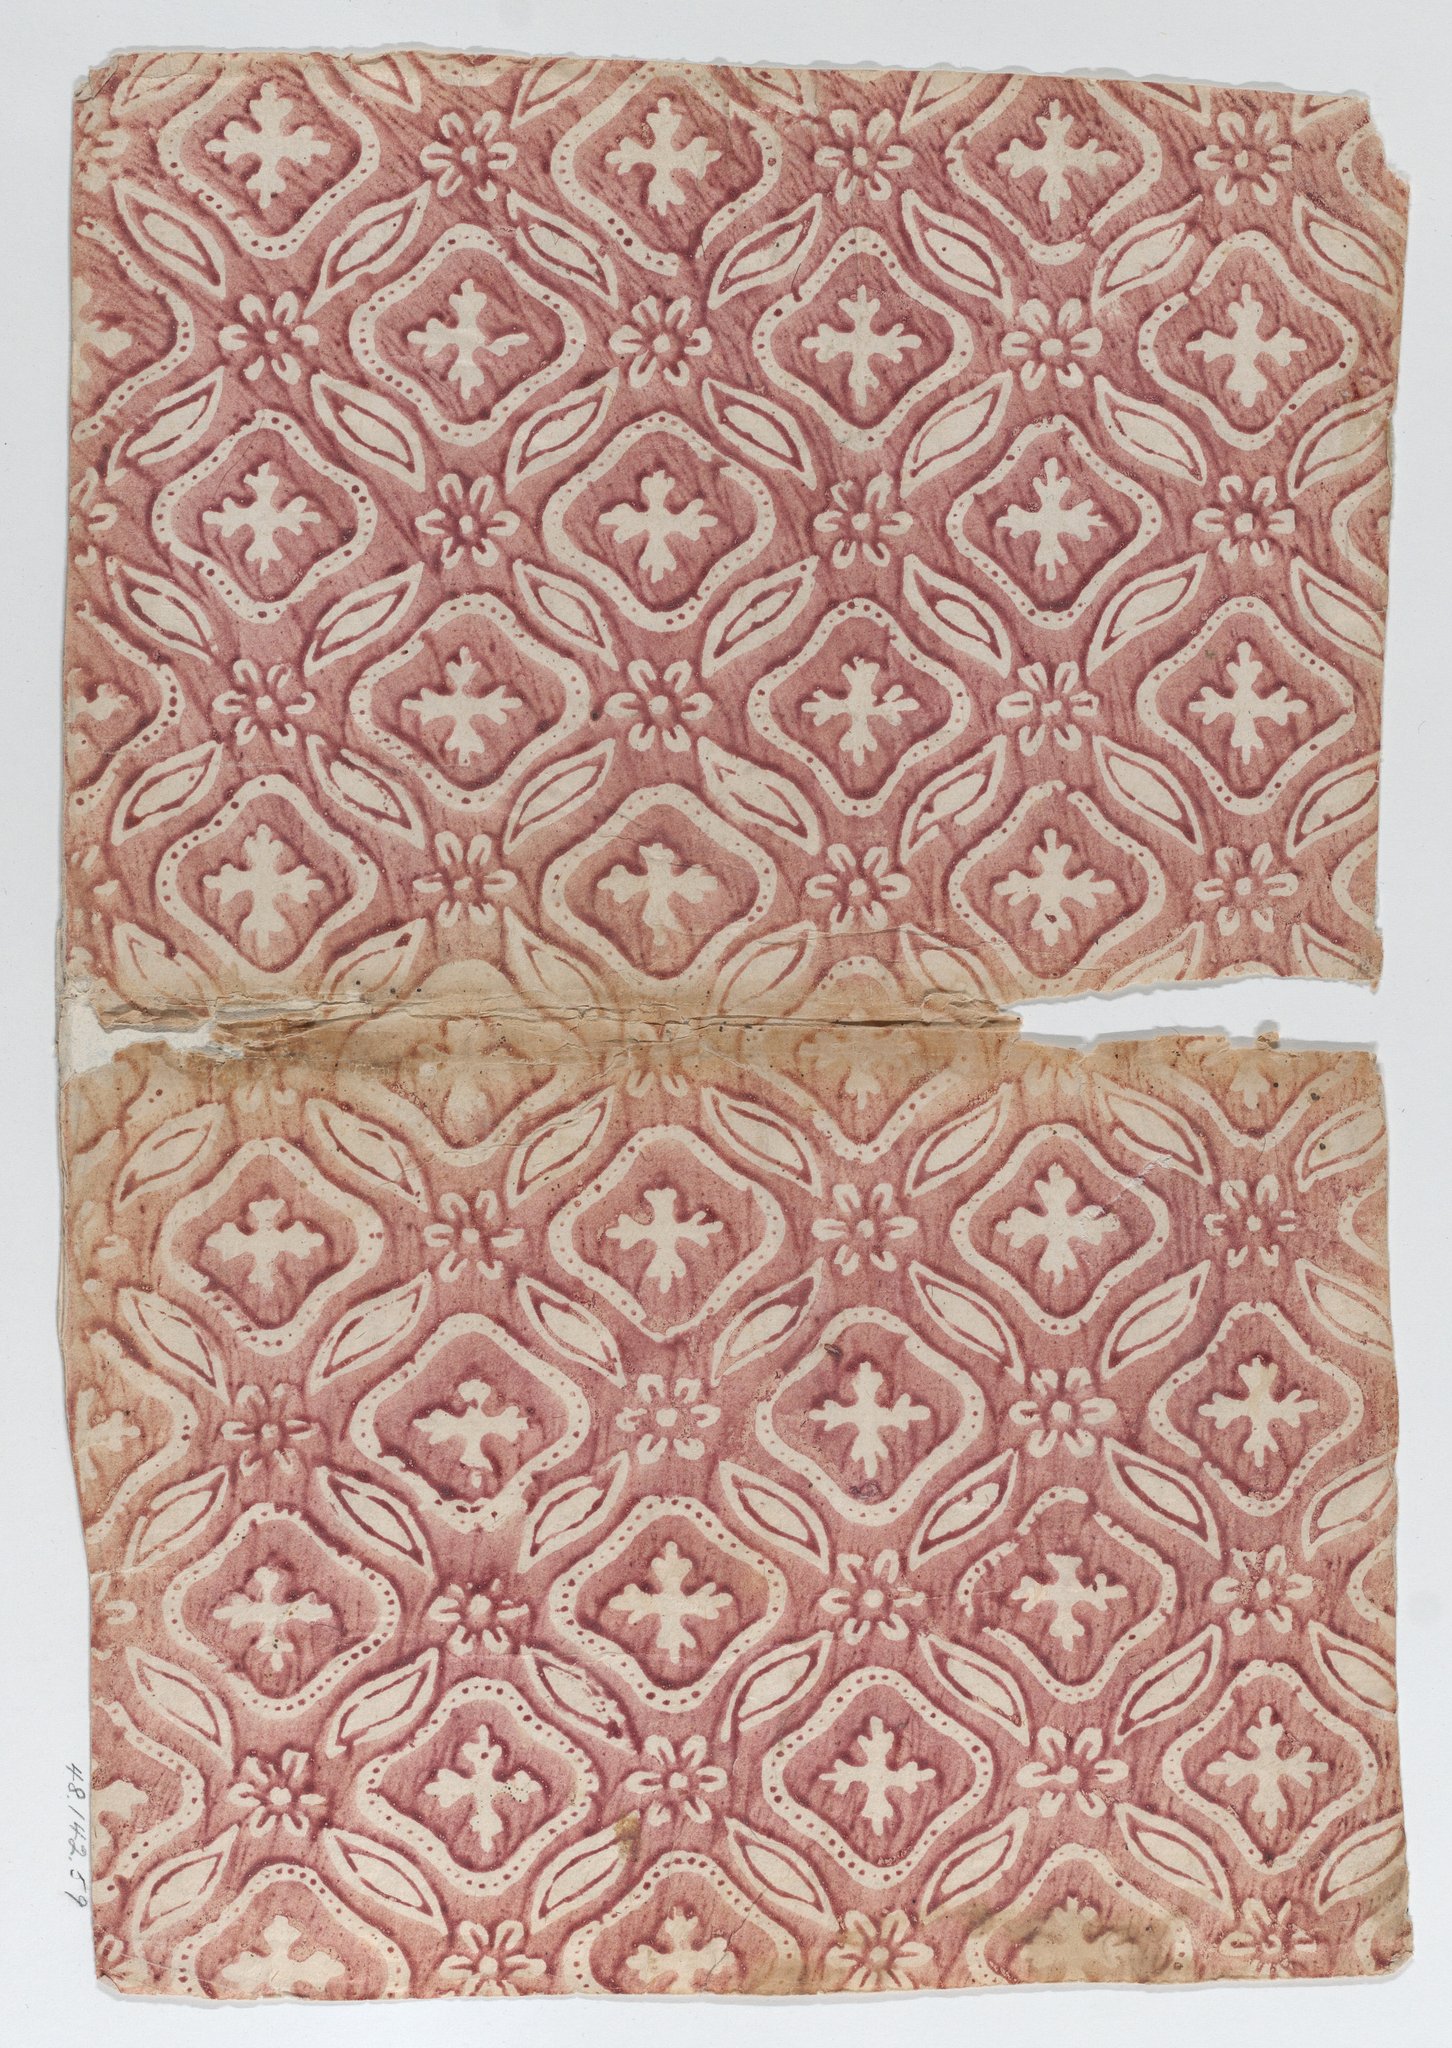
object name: print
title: Book cover with red floral and abstract pattern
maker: Anonymous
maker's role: artist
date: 1701-1800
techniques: relief print